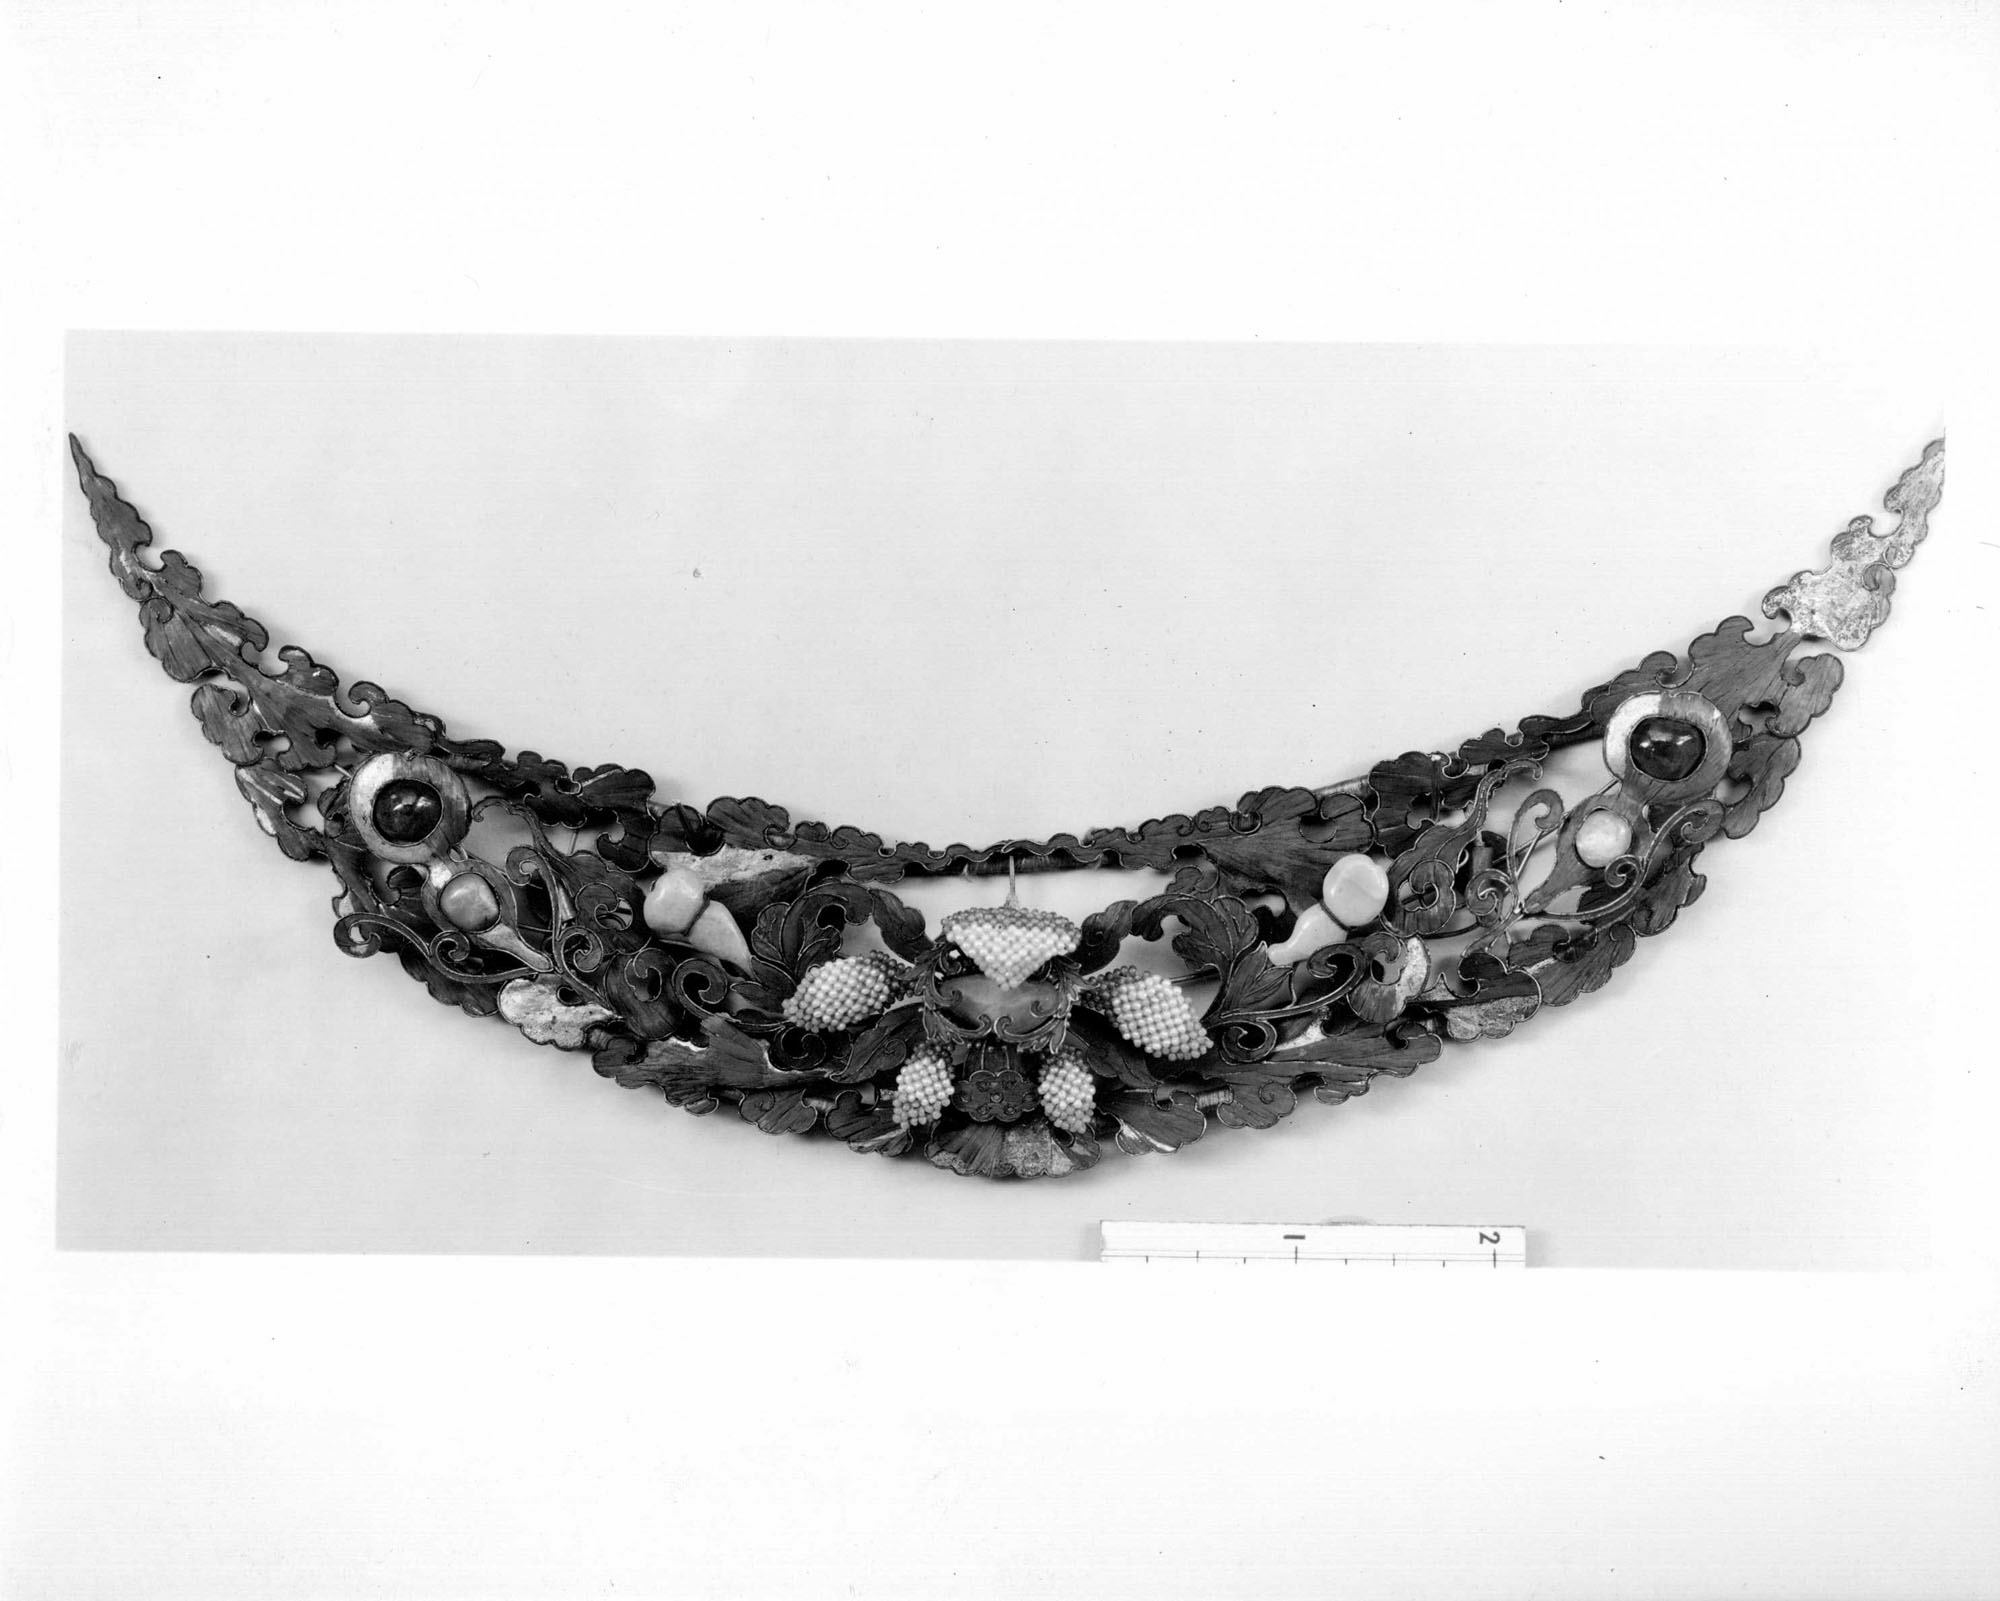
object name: headdress ornament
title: Ornament for Headdress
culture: chinese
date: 1701-1900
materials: feather, gemstone, gold, jade, pearl